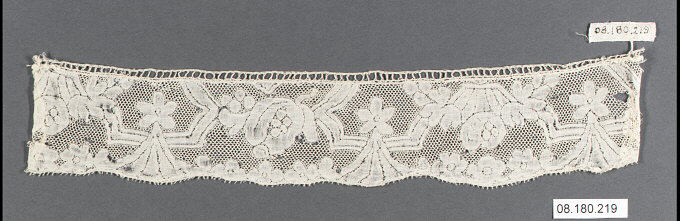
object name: fragment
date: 1701-1800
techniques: lace